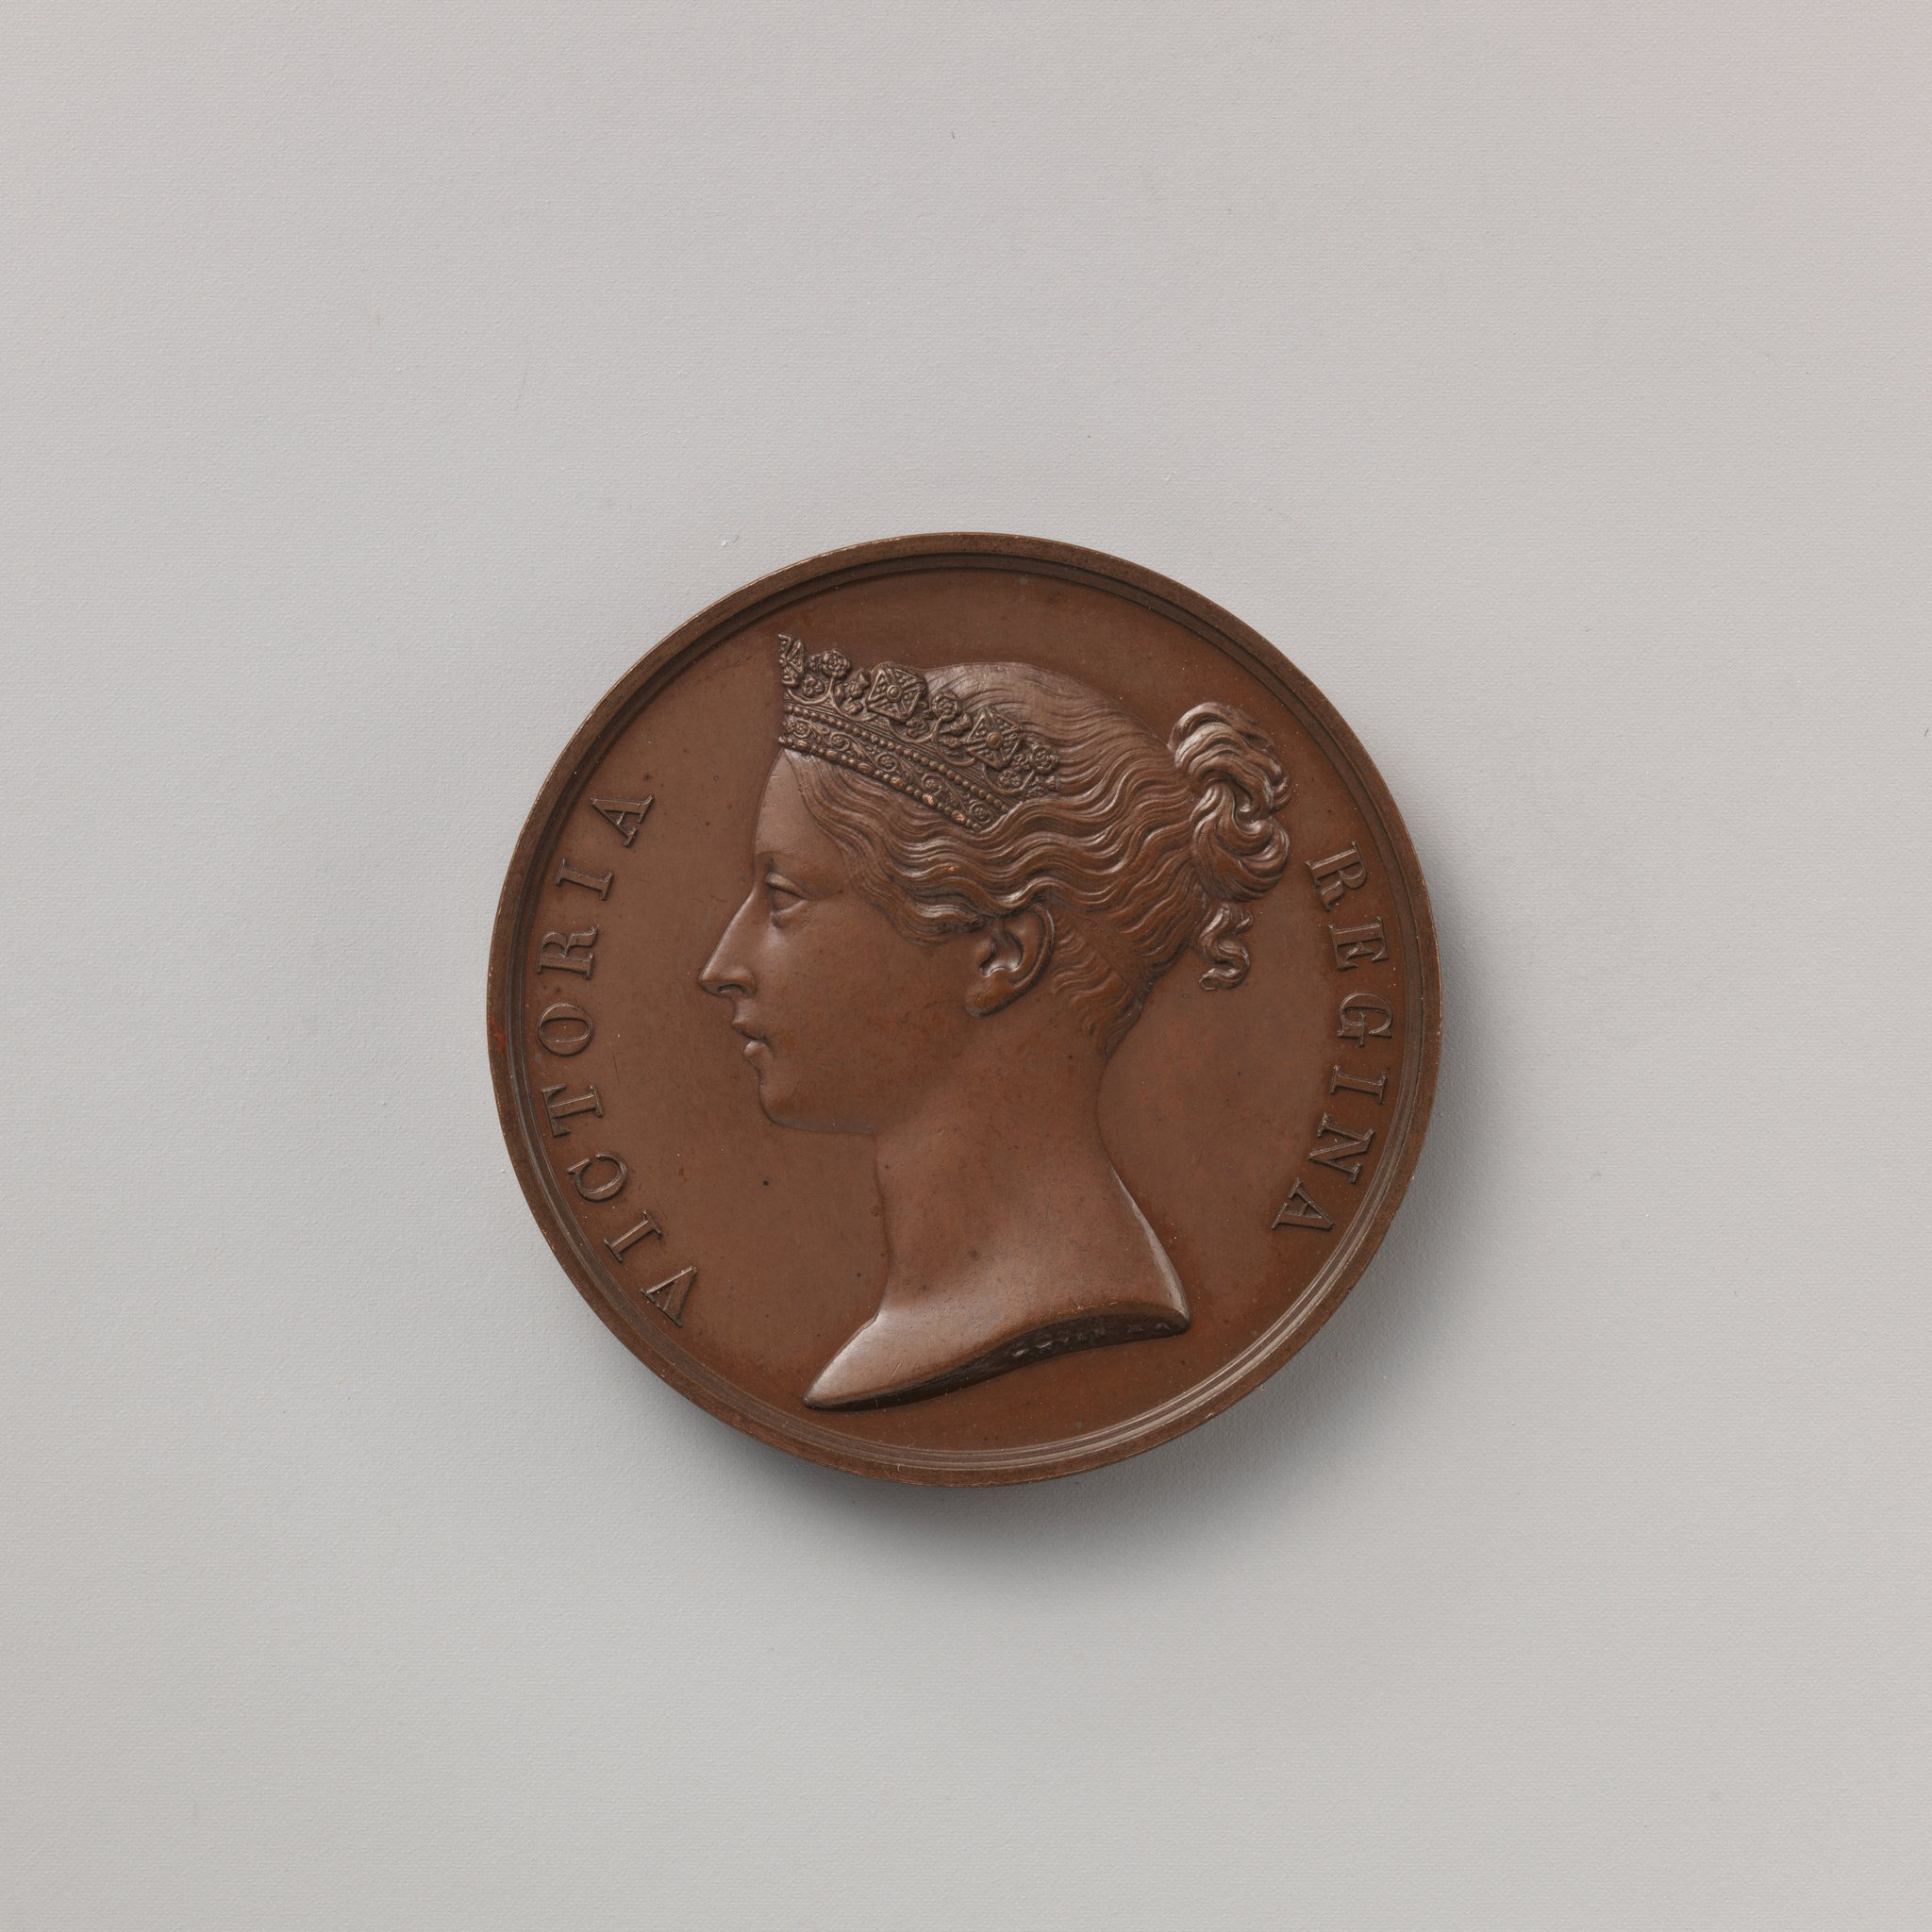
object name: medal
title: The Scinde Medal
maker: william wyon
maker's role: artist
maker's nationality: british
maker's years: 1795-1851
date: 1843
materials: bronze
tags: profiles